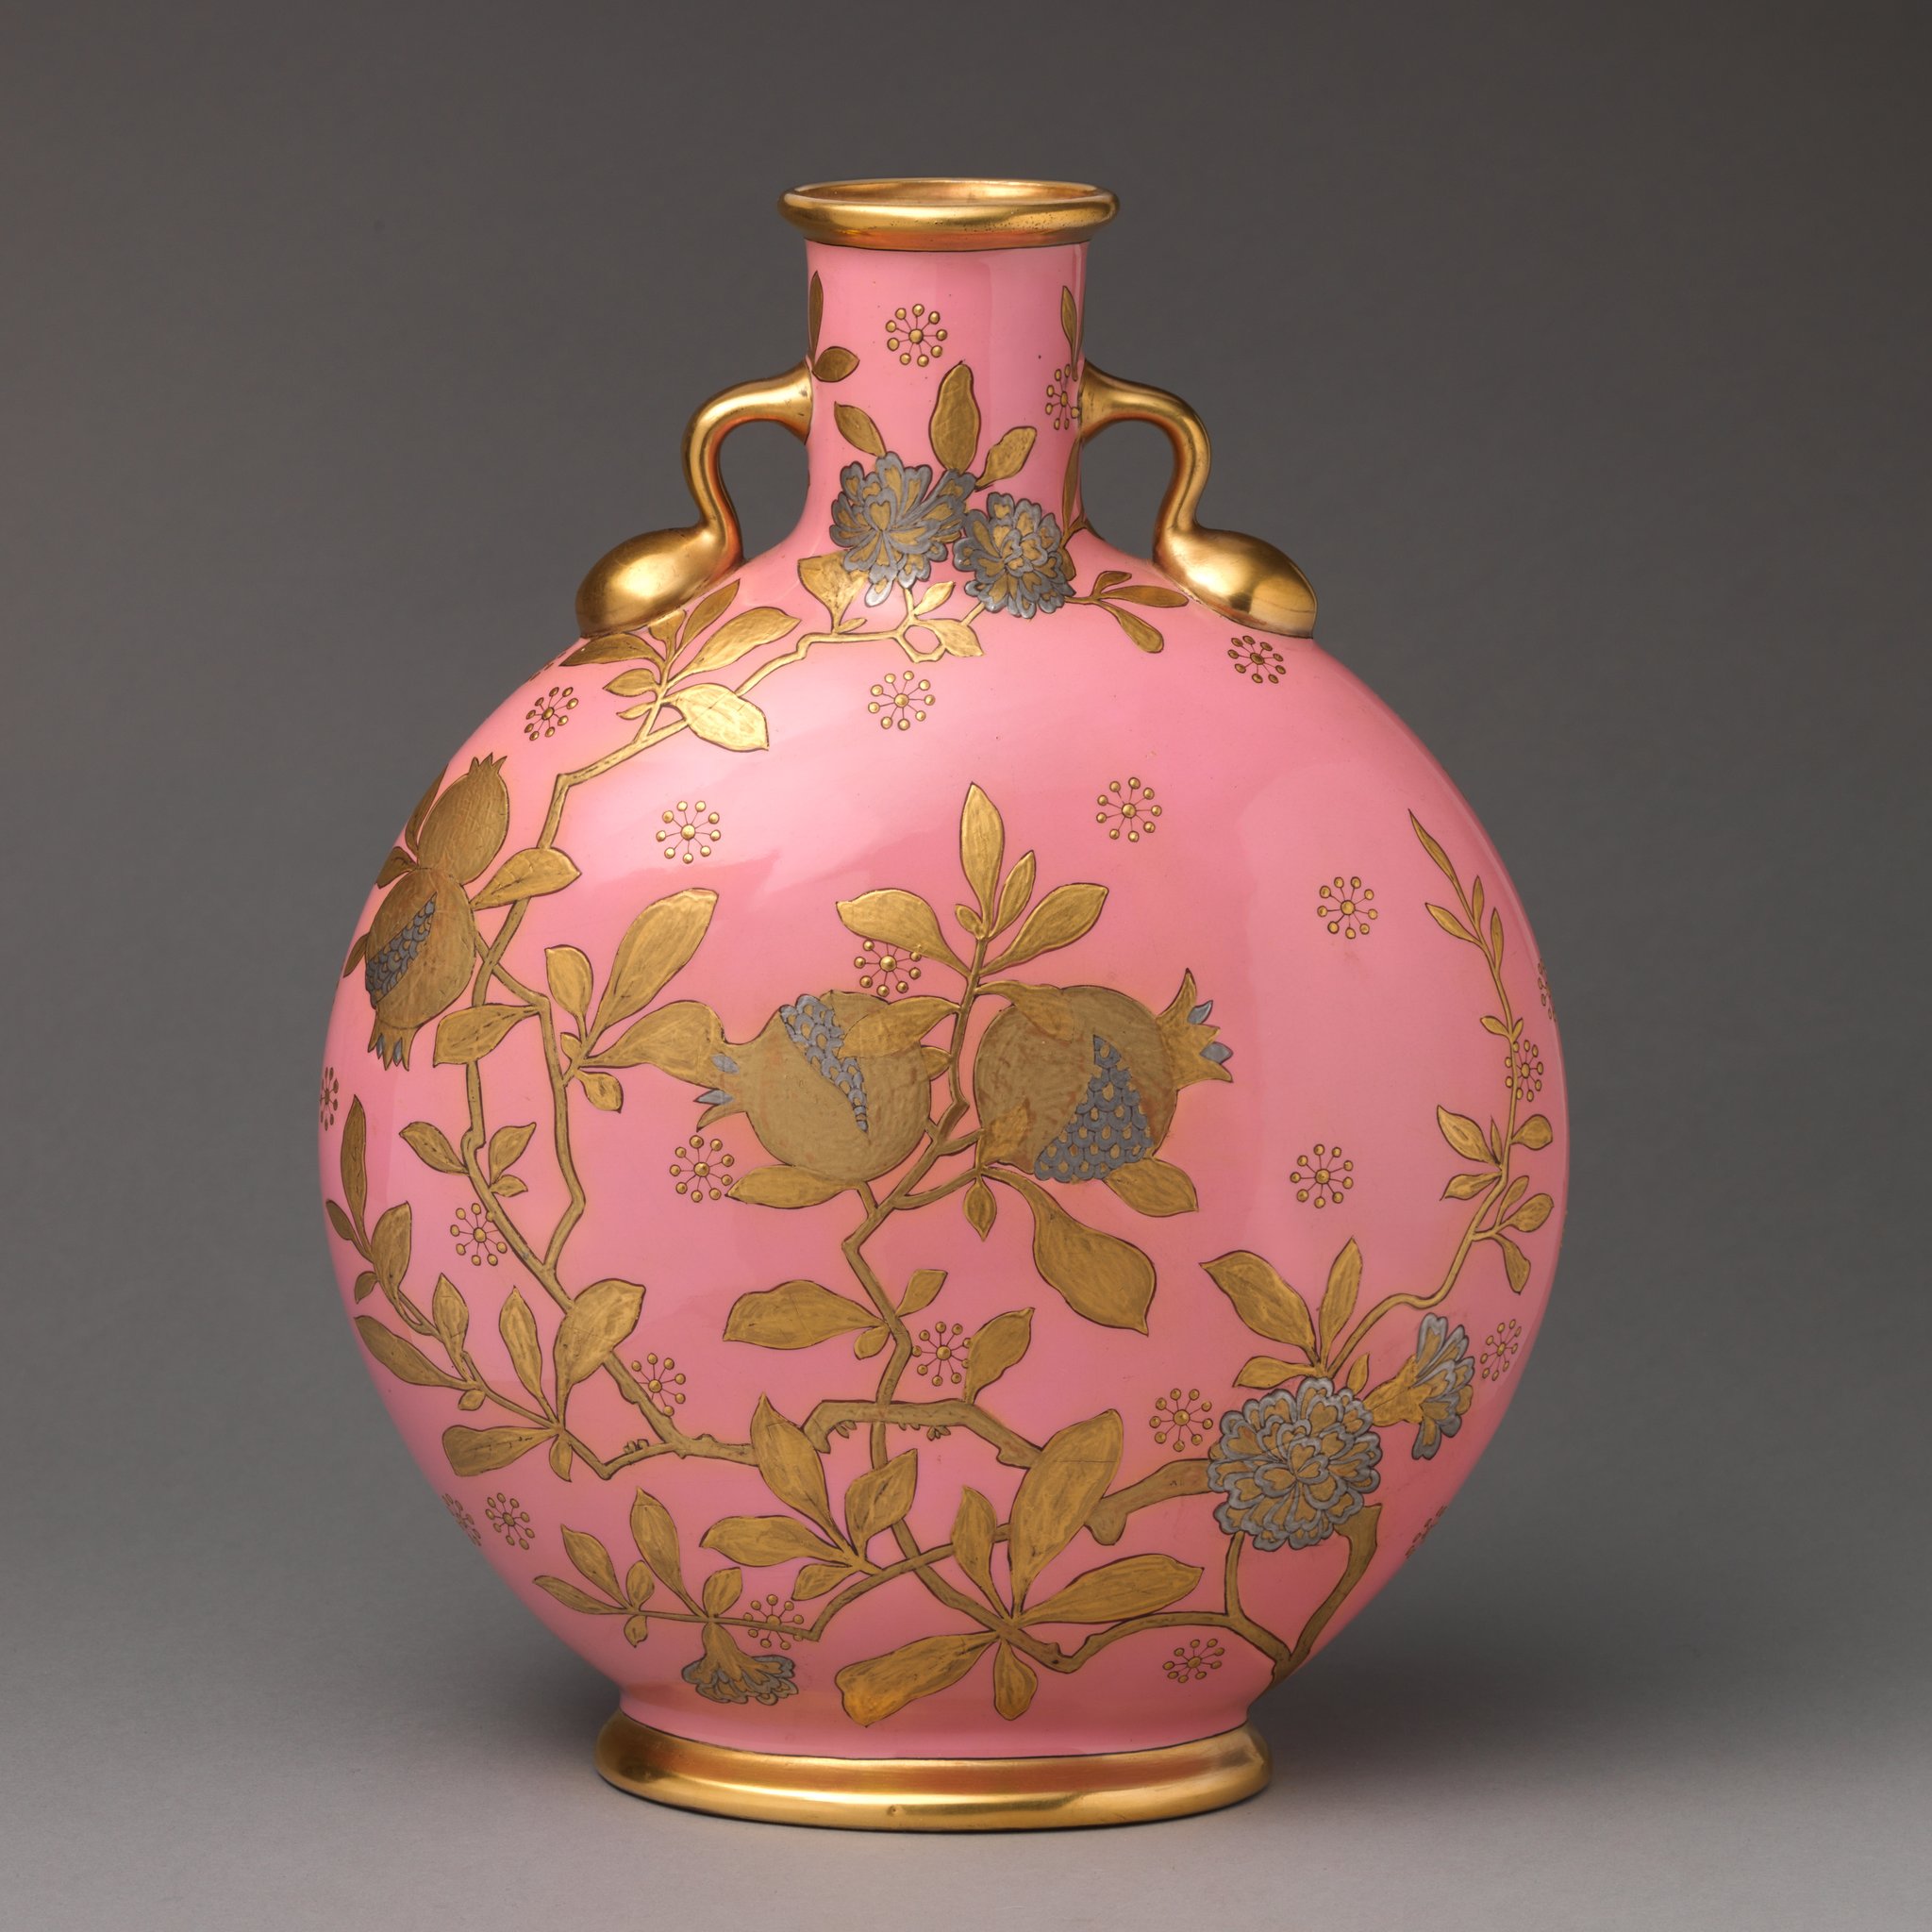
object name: moon flask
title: Moon flask with gilt floral decoration on pink ground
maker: minton(s)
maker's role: maker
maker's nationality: british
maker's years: 1793-2001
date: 1875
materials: bone china